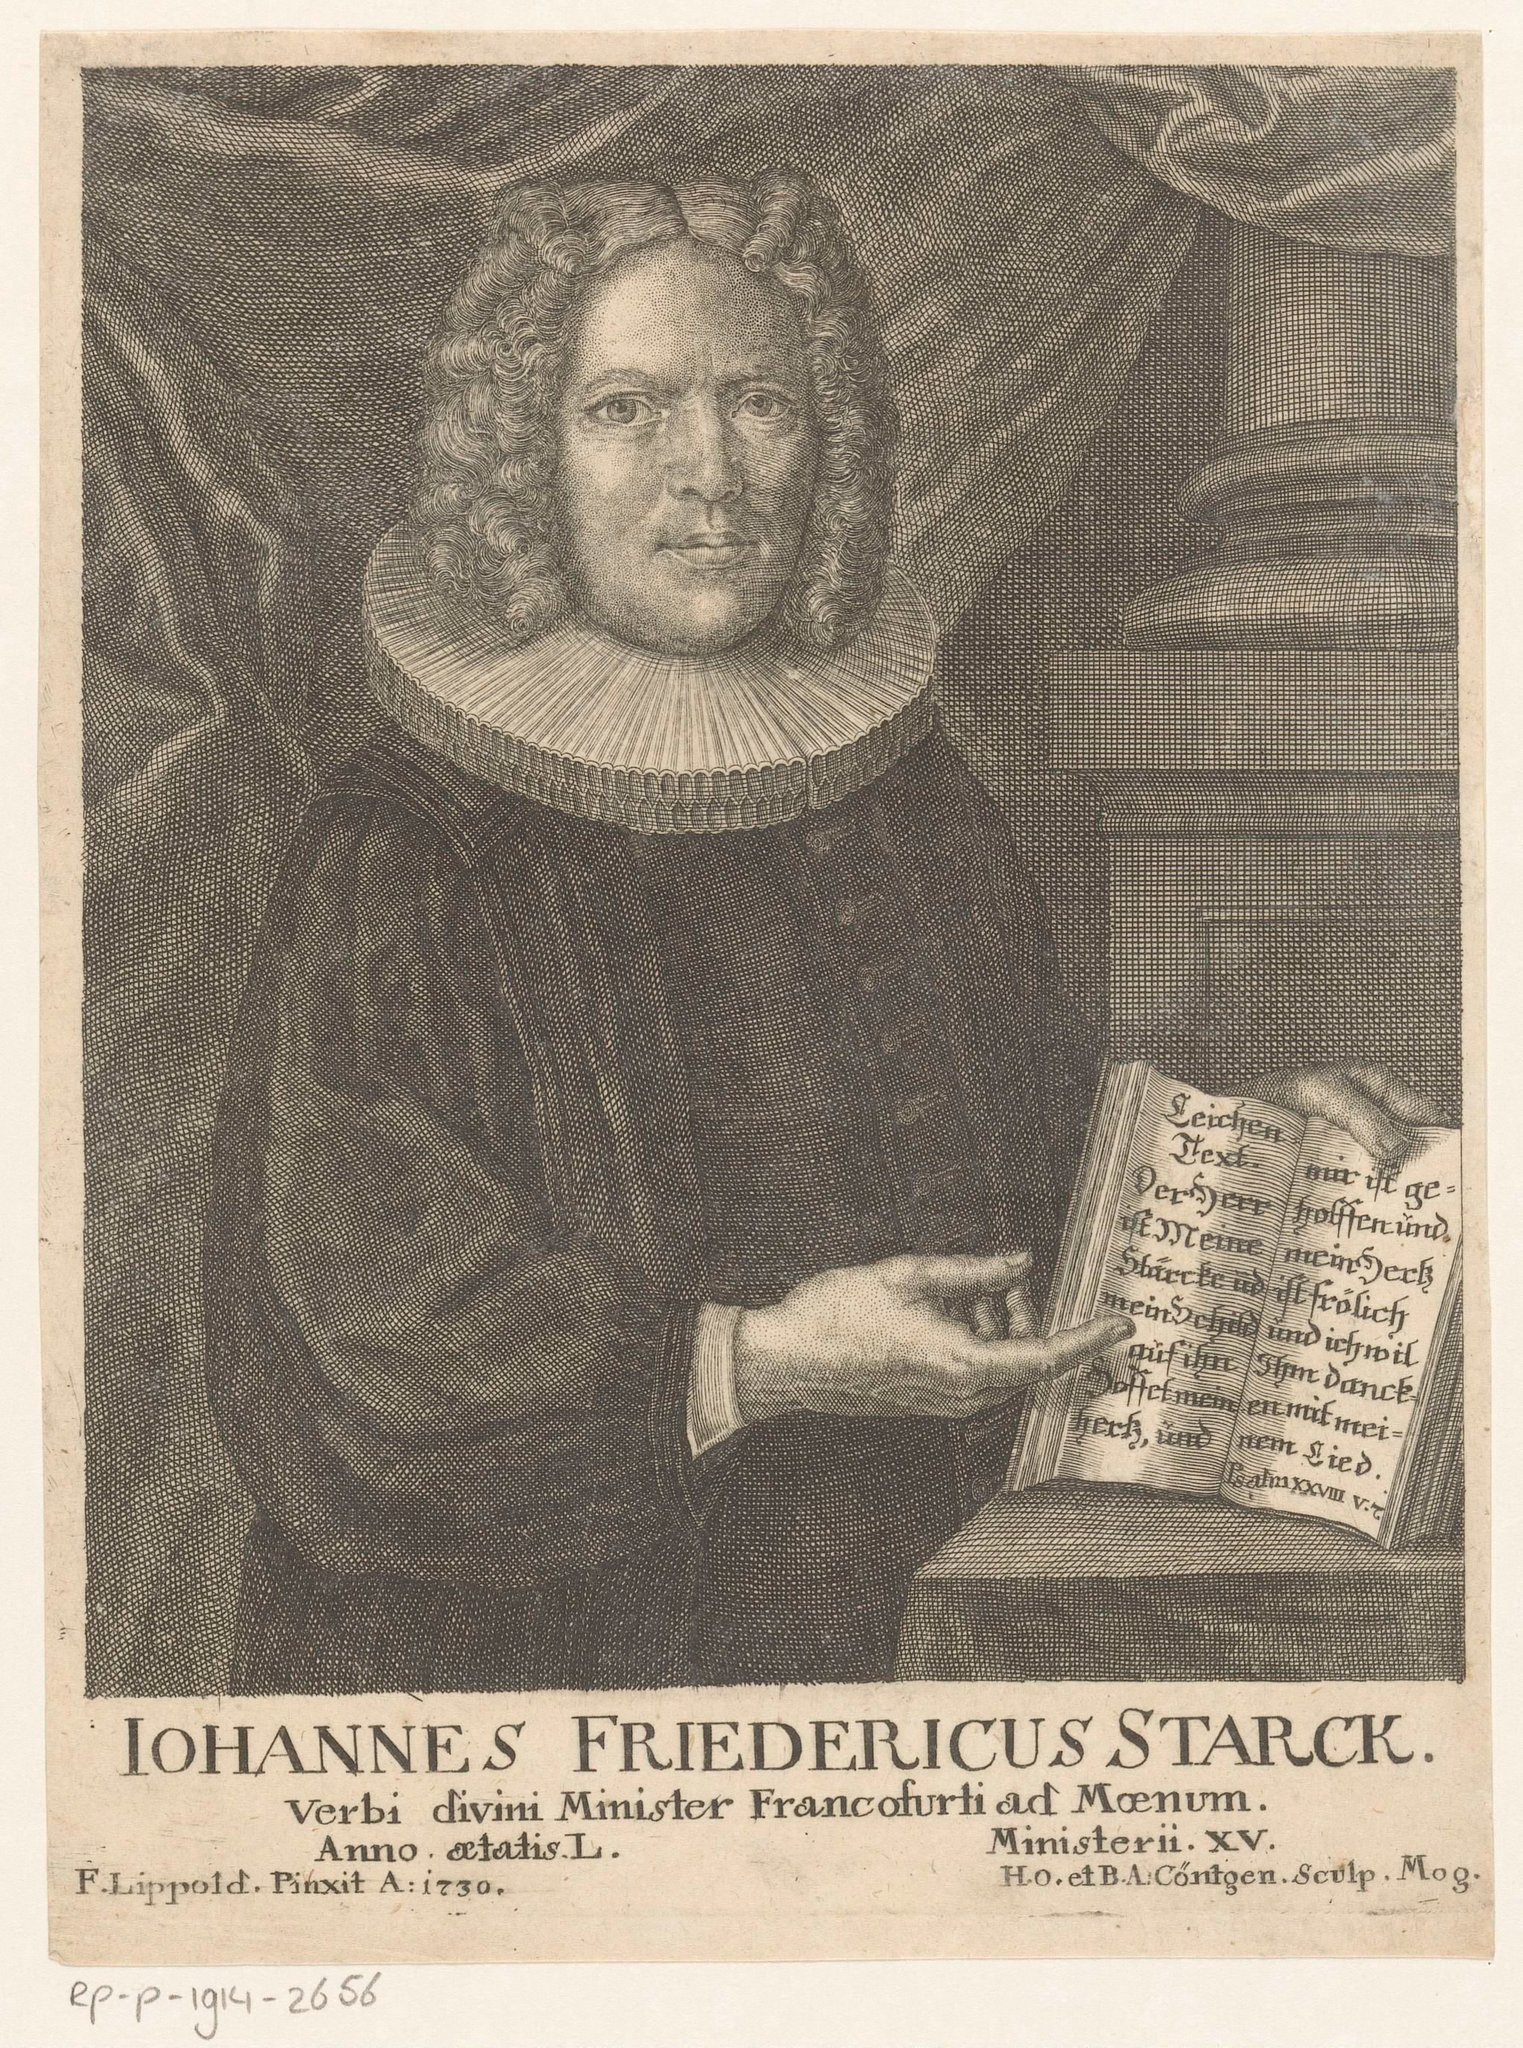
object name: print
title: Portret van Johann Friedrich Starck op 50-jarige leeftijd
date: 1730-1739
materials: paper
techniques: engraving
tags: historical persons, the book of psalms, index finger forwards, pointing, indicating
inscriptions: collector's mark: Lugt 2228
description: Portret van Johann Friedrich Starck met in zijn hand een bijbel met tekst uit Psalmen 28:7: "Der HERR ist meine Stärke und mein Schild; auf ihn traut mein Herz und mir ist geholfen. Nun ist mein Herz fröhlich, und ich will ihm danken mit meinem Lied".